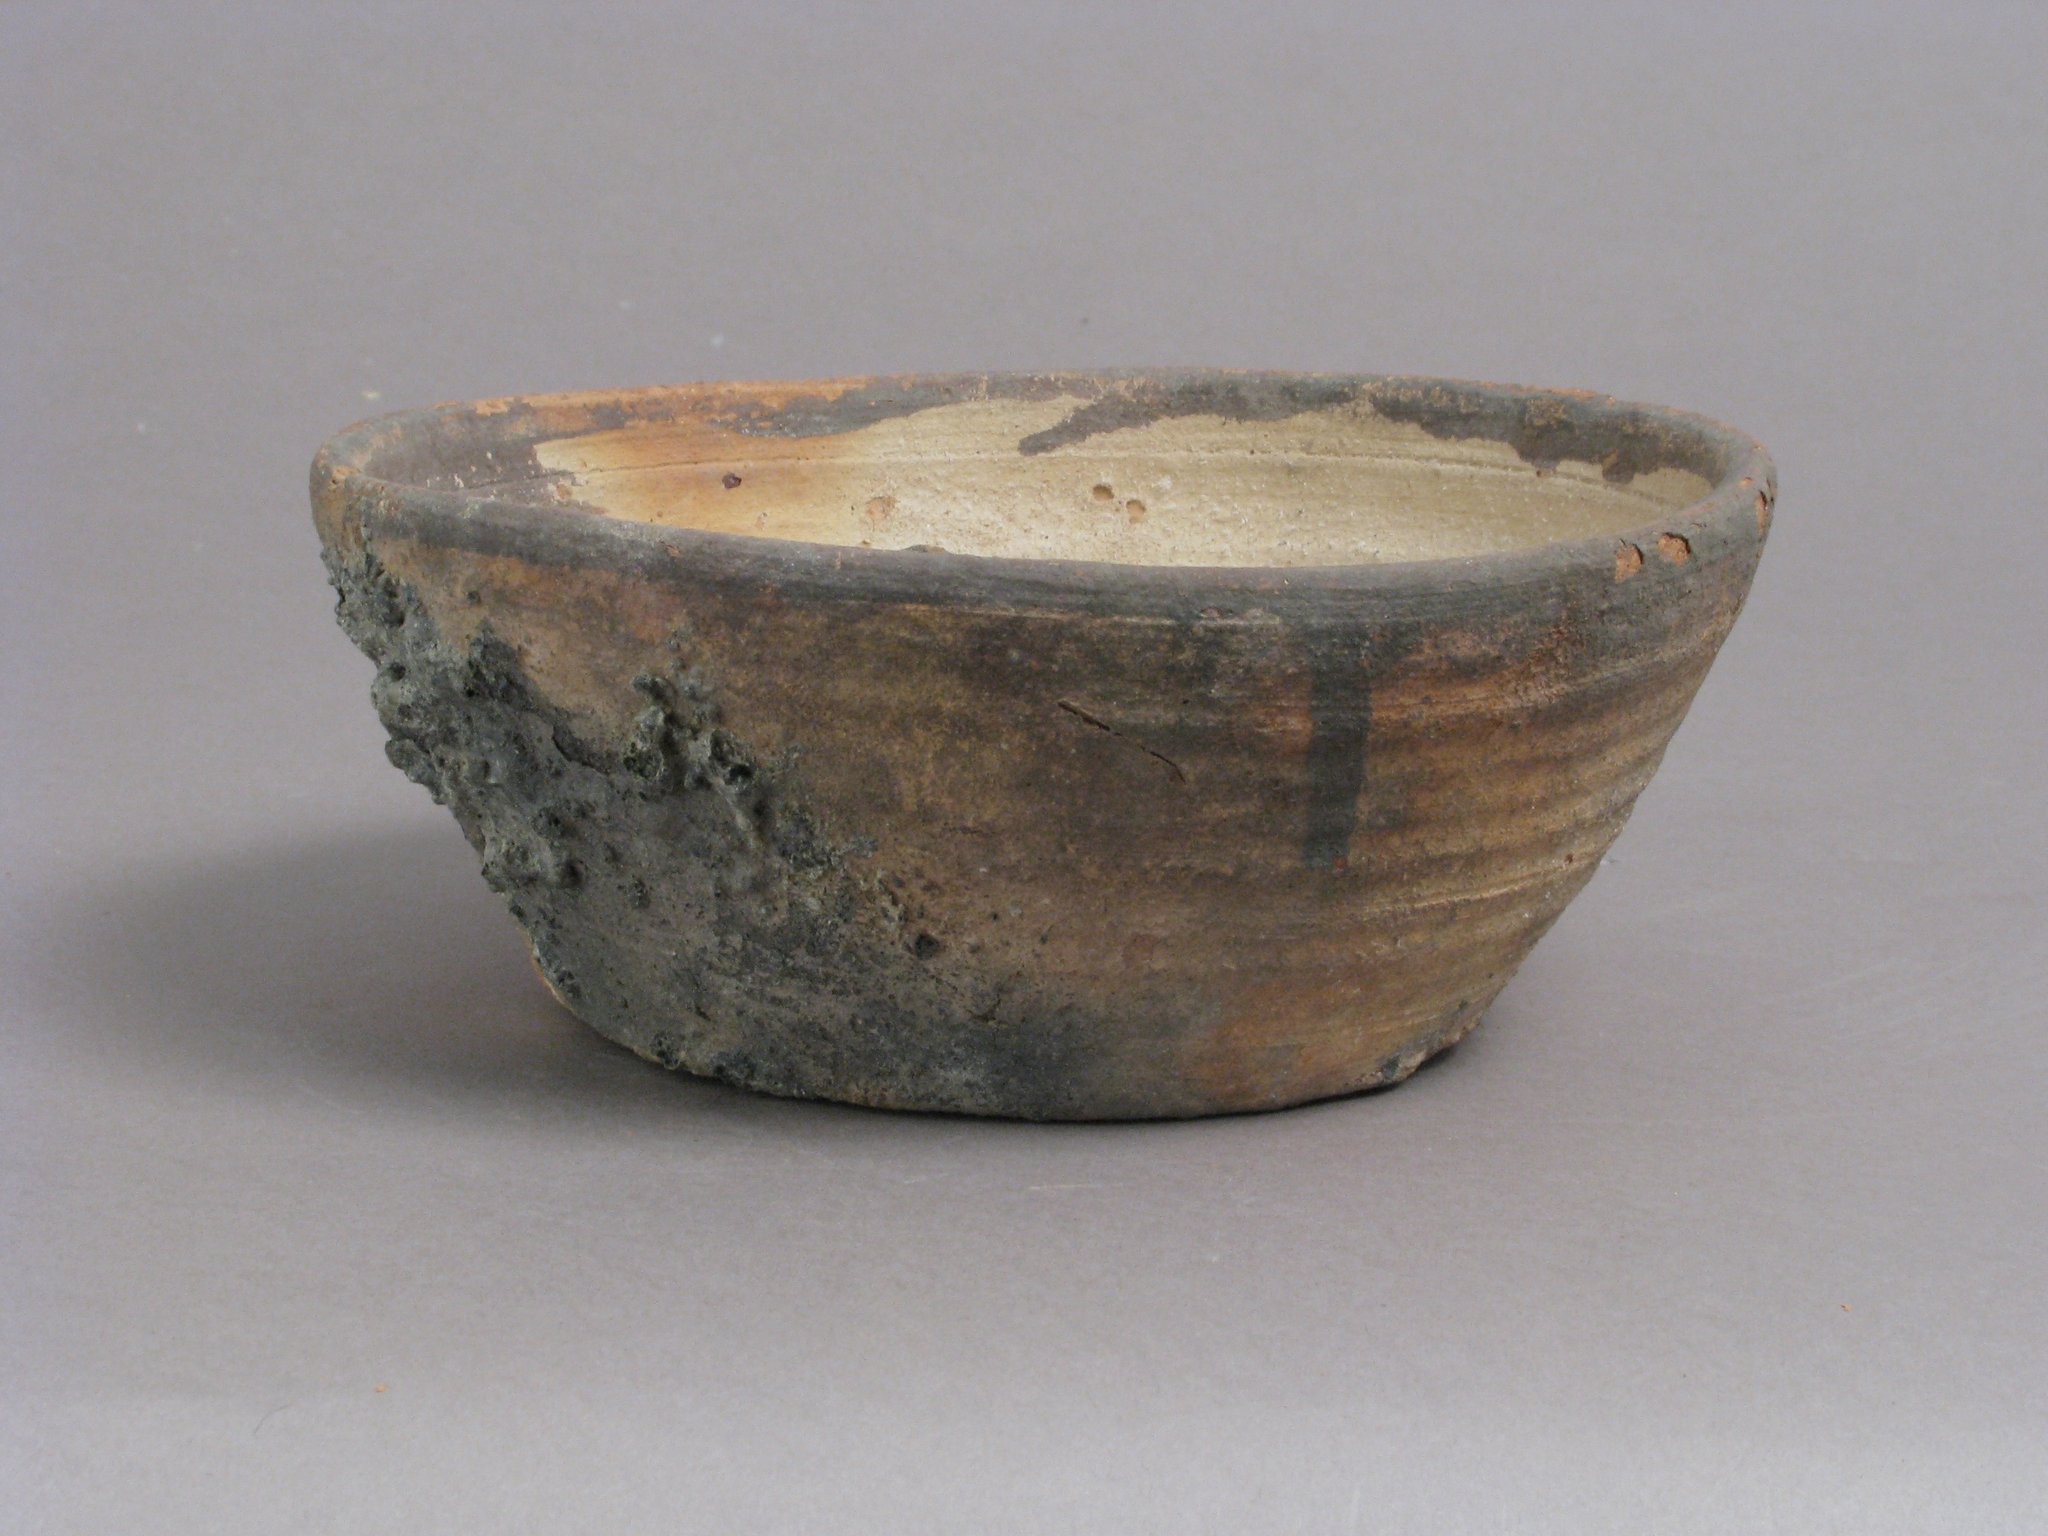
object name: bowl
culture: coptic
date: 301-700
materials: earthenware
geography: egypt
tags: bowls